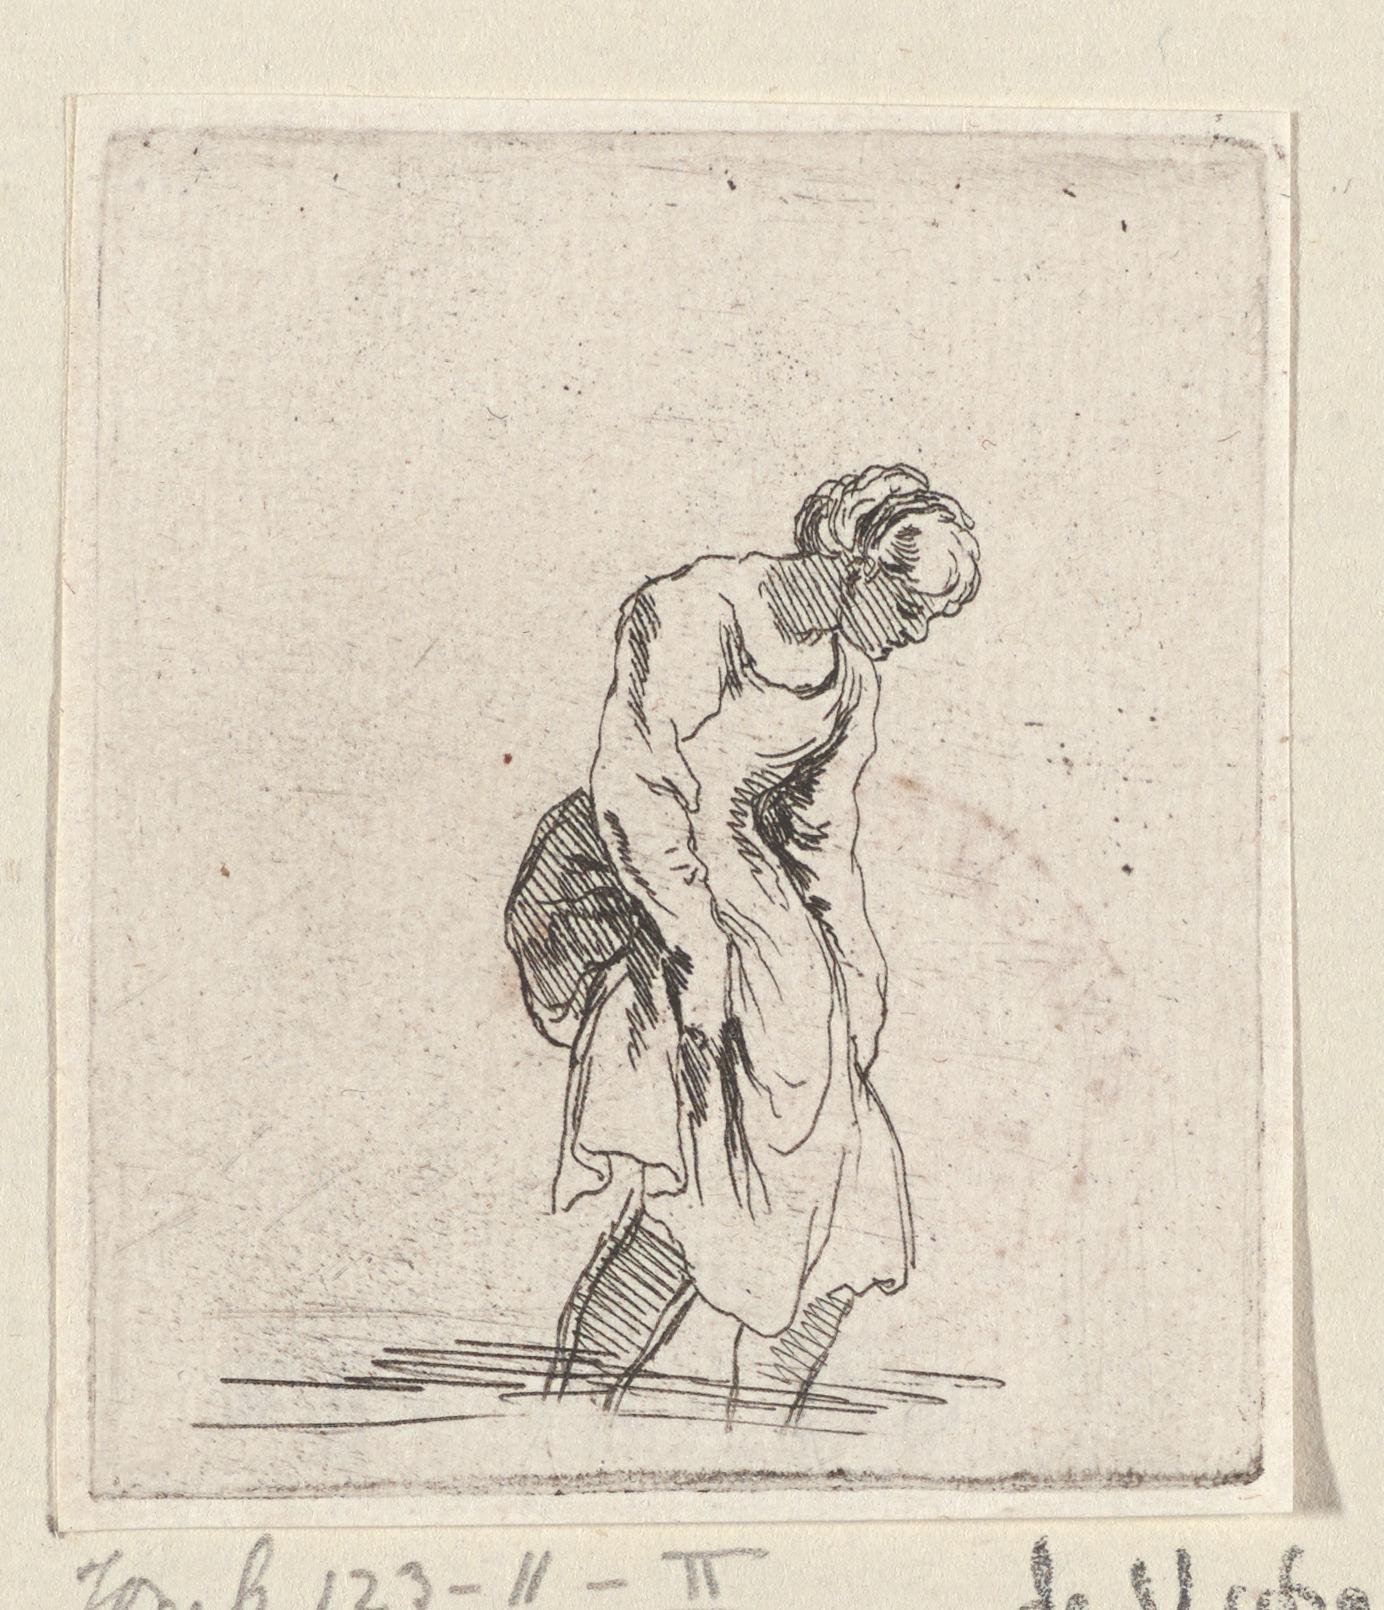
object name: print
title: Pootjebadende vrouw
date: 1620-1664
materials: paper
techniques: etching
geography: paris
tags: adult woman, wading, paddling - aa - female human figure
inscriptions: collector's mark: Lugt 240